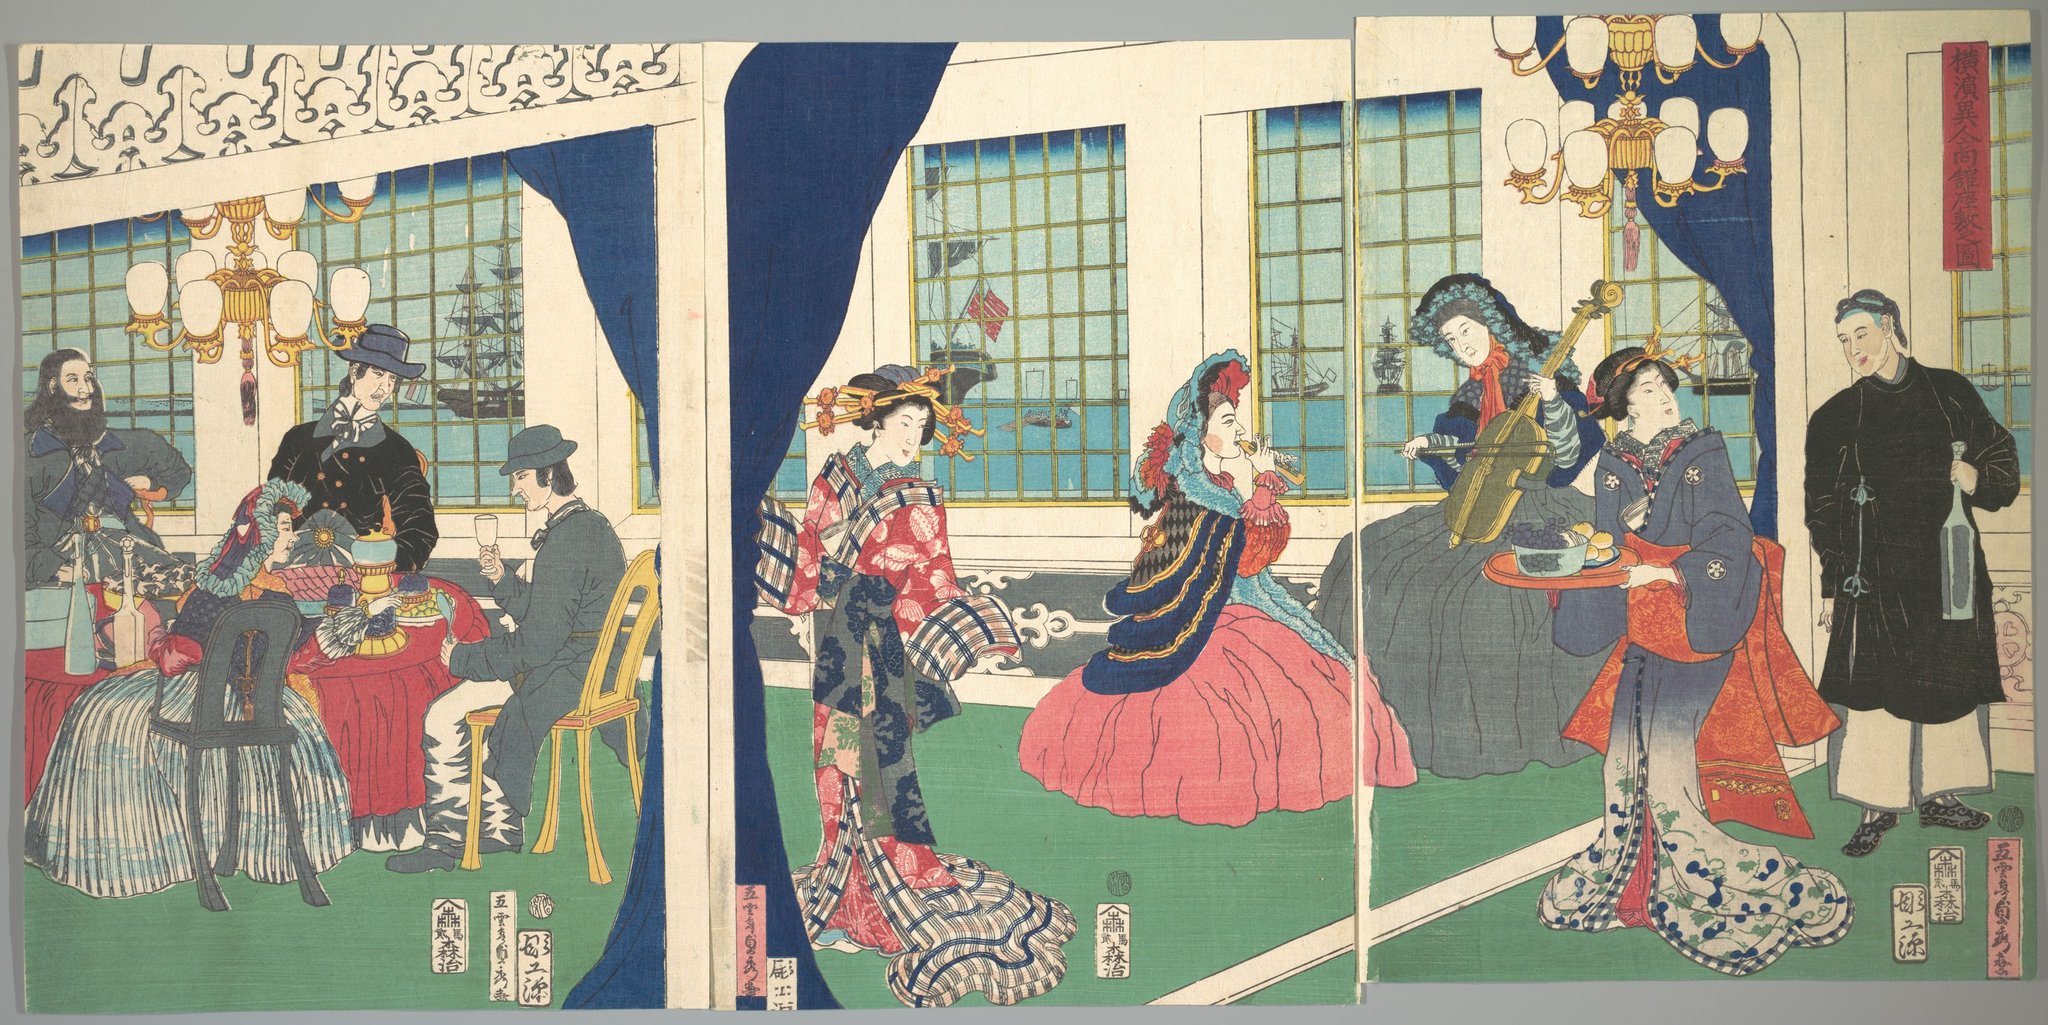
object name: print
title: Foreigners in the Drawing Room of Foreign Merchant's House in Yokohama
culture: japanese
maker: utagawa (gountei) sadahide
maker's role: artist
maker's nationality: japanese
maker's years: 1807-1873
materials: ink, paper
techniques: woodblock print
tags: musical instruments,interiors,men,women,dining